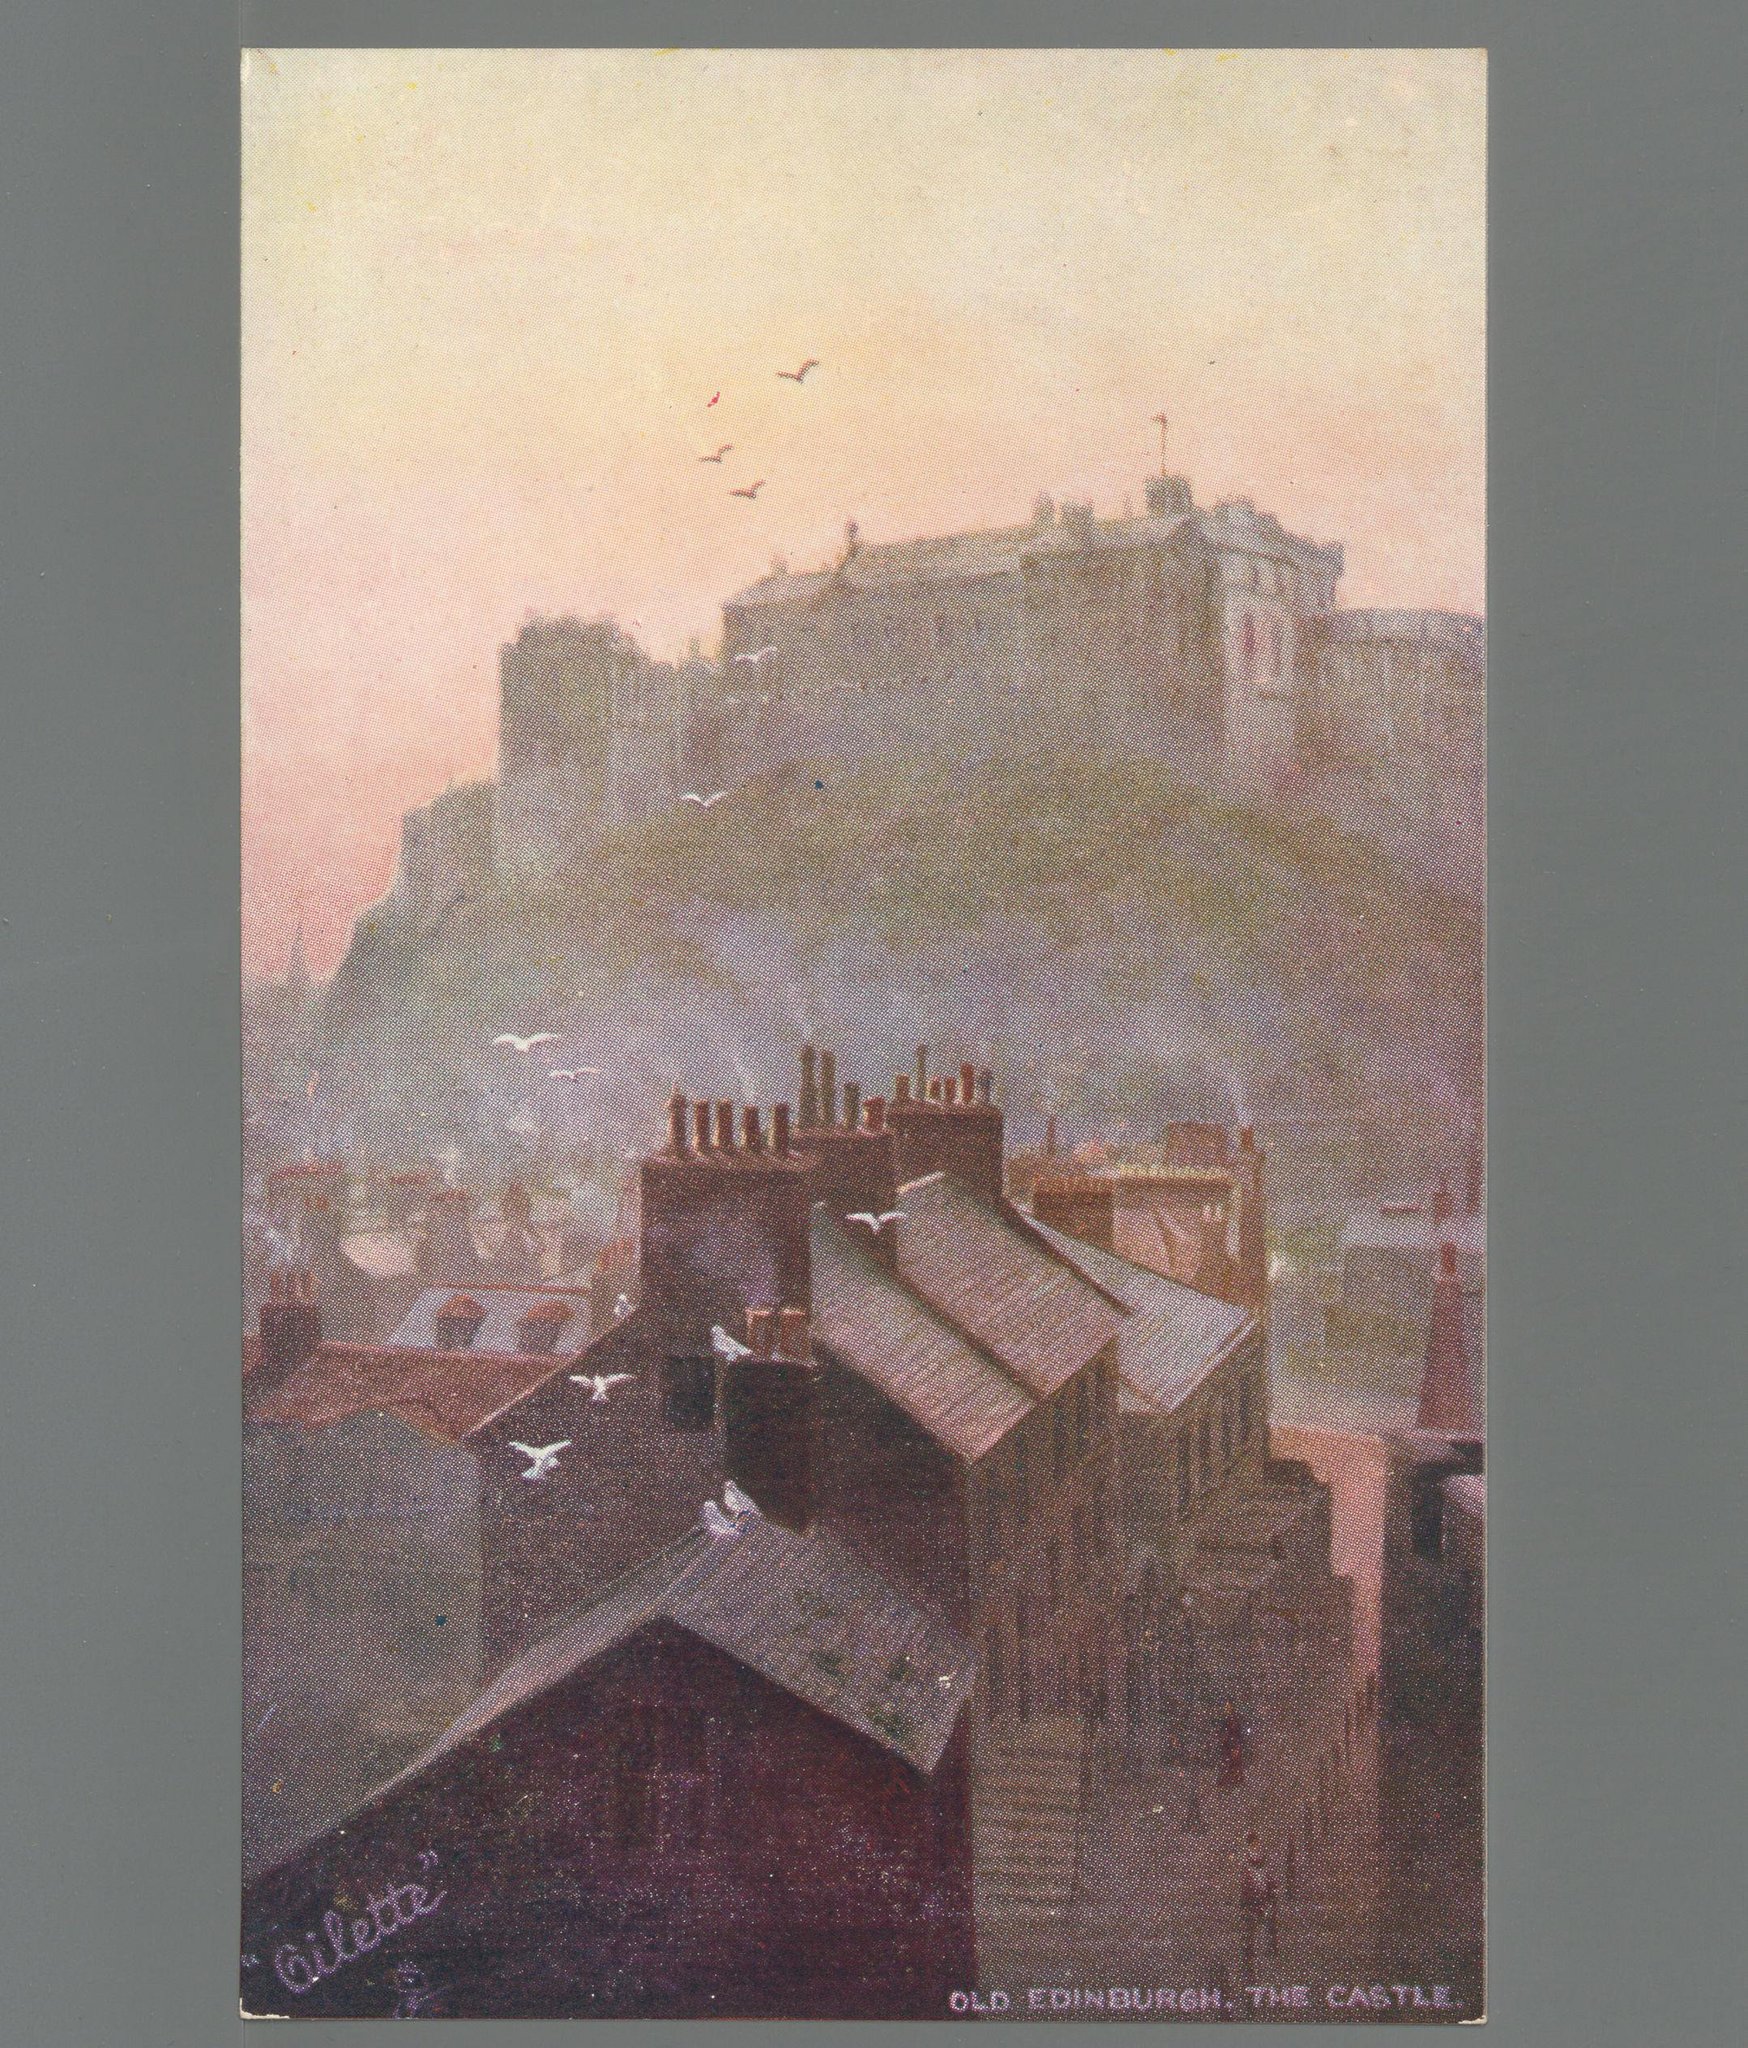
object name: ansichtkaart, prentbriefkaart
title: Oilette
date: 1905-1930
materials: cardboard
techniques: color autotype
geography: england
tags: castle